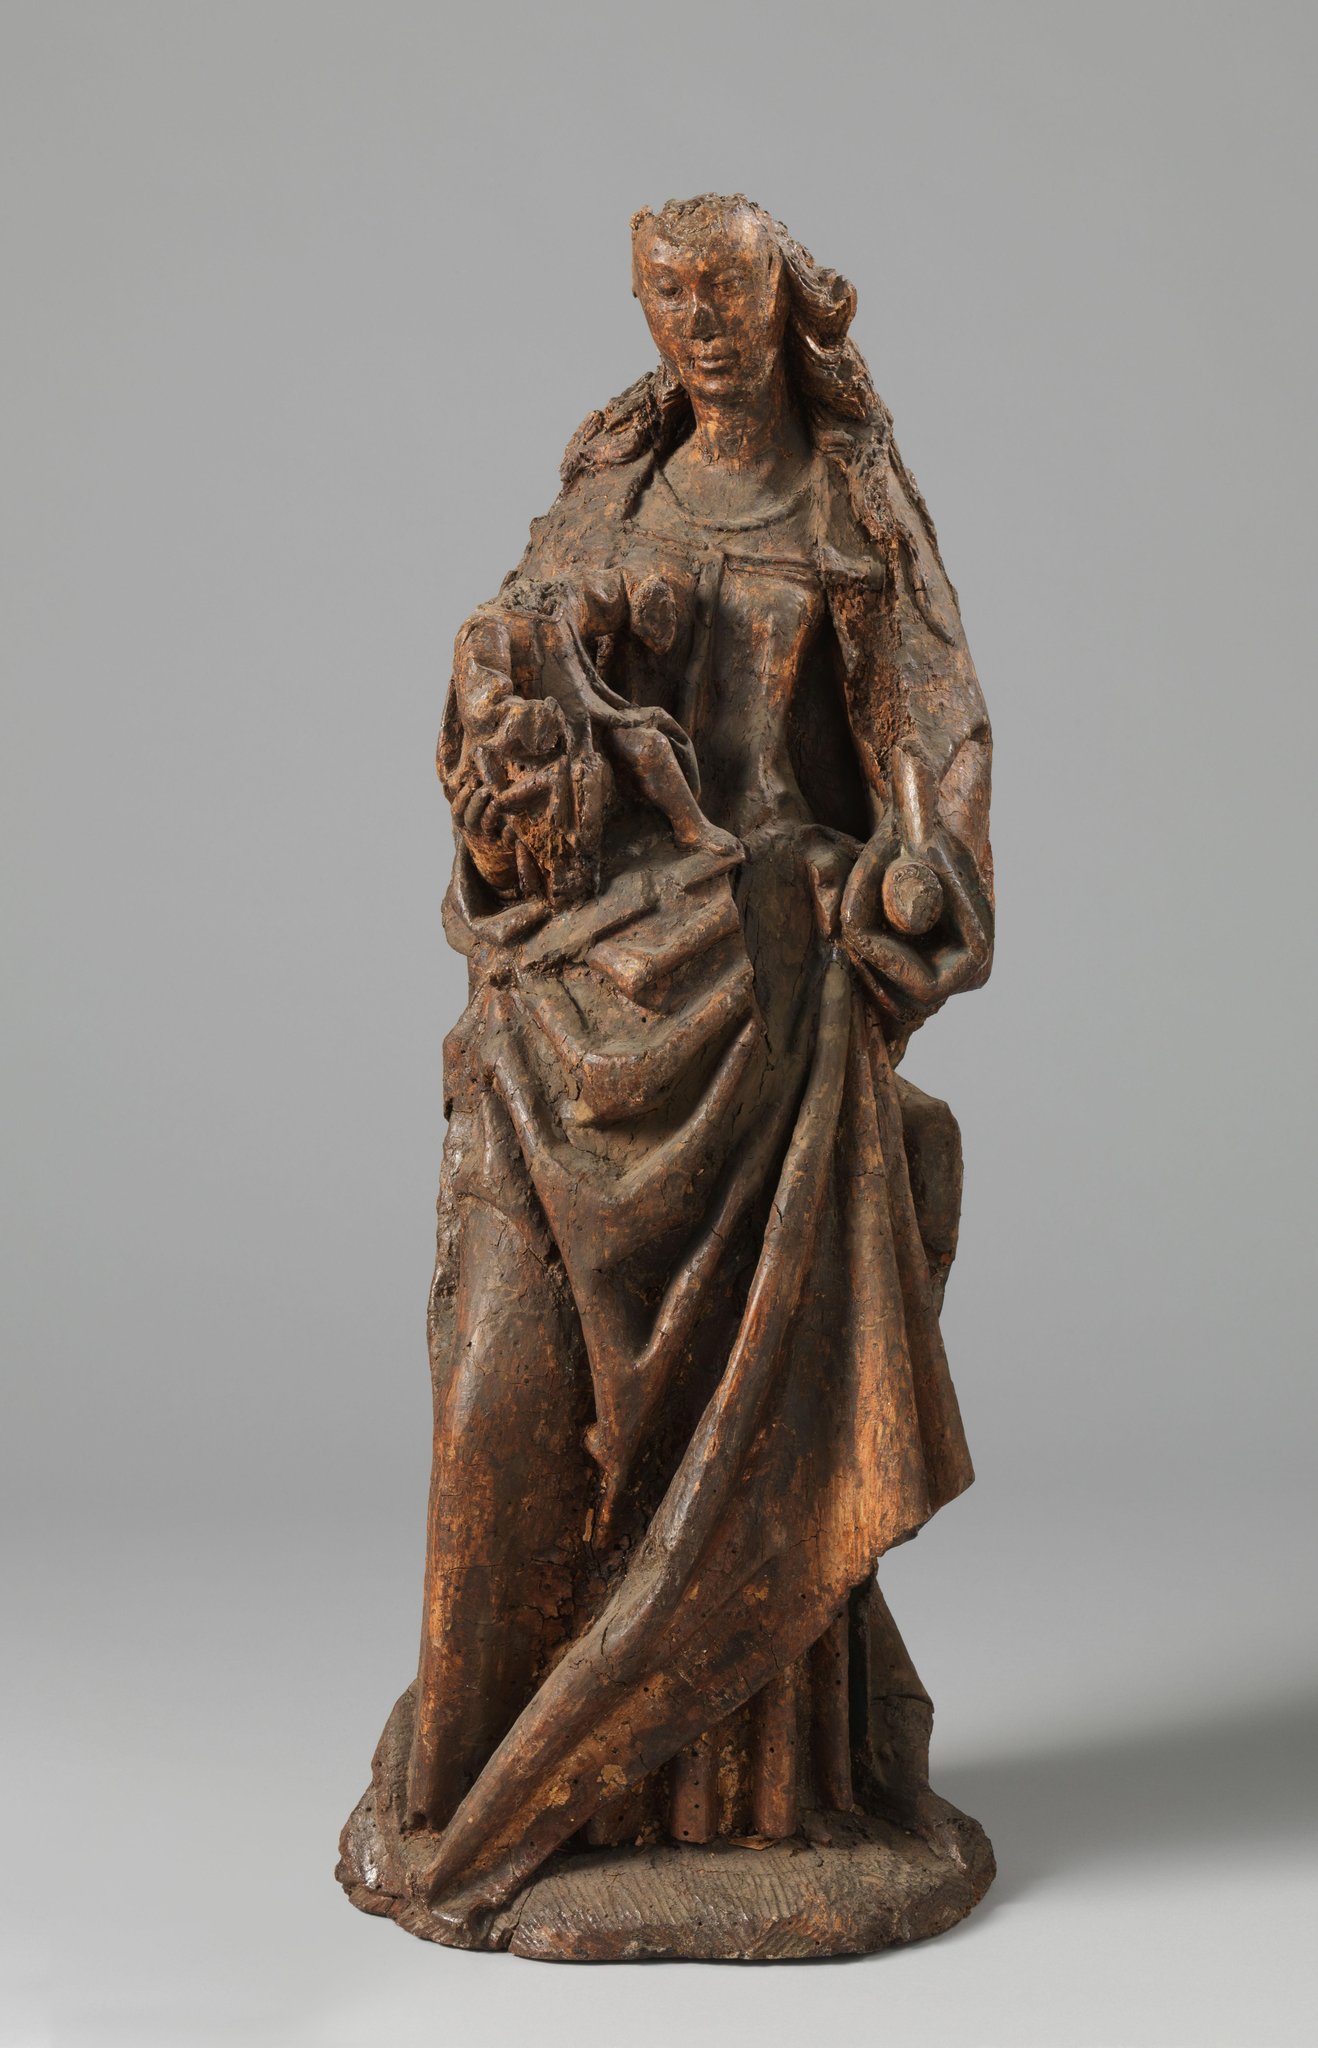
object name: sculpture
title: Virgin and Child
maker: Anonymous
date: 1490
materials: wood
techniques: gilding, polychromy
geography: utrecht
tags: mary standing (or half-length), the christ-child in front of her, close to her bosom; sitting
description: Zij staat op een grondje met het gebogen rechterbeen naar voren en de punt van de schoen in de mantel, waardoor een diagonale plooi ontstaat. Het in een hemdje geklede kind zit op Maria's rechterhand. Zij ziet peinzend voor zich uit; het haar valt in enkele dikke strengen langs de slapen en voor de schouders. Zij draagt over een kleed met ronde halsuitsnijding een voor de borst met een dubbele band samengebonden mantel, welke onder beide armen wordt opgehouden, voor de schoot naar rechts is toegeslagen en waaronder nog een deel van het kleed zichtbaar is.